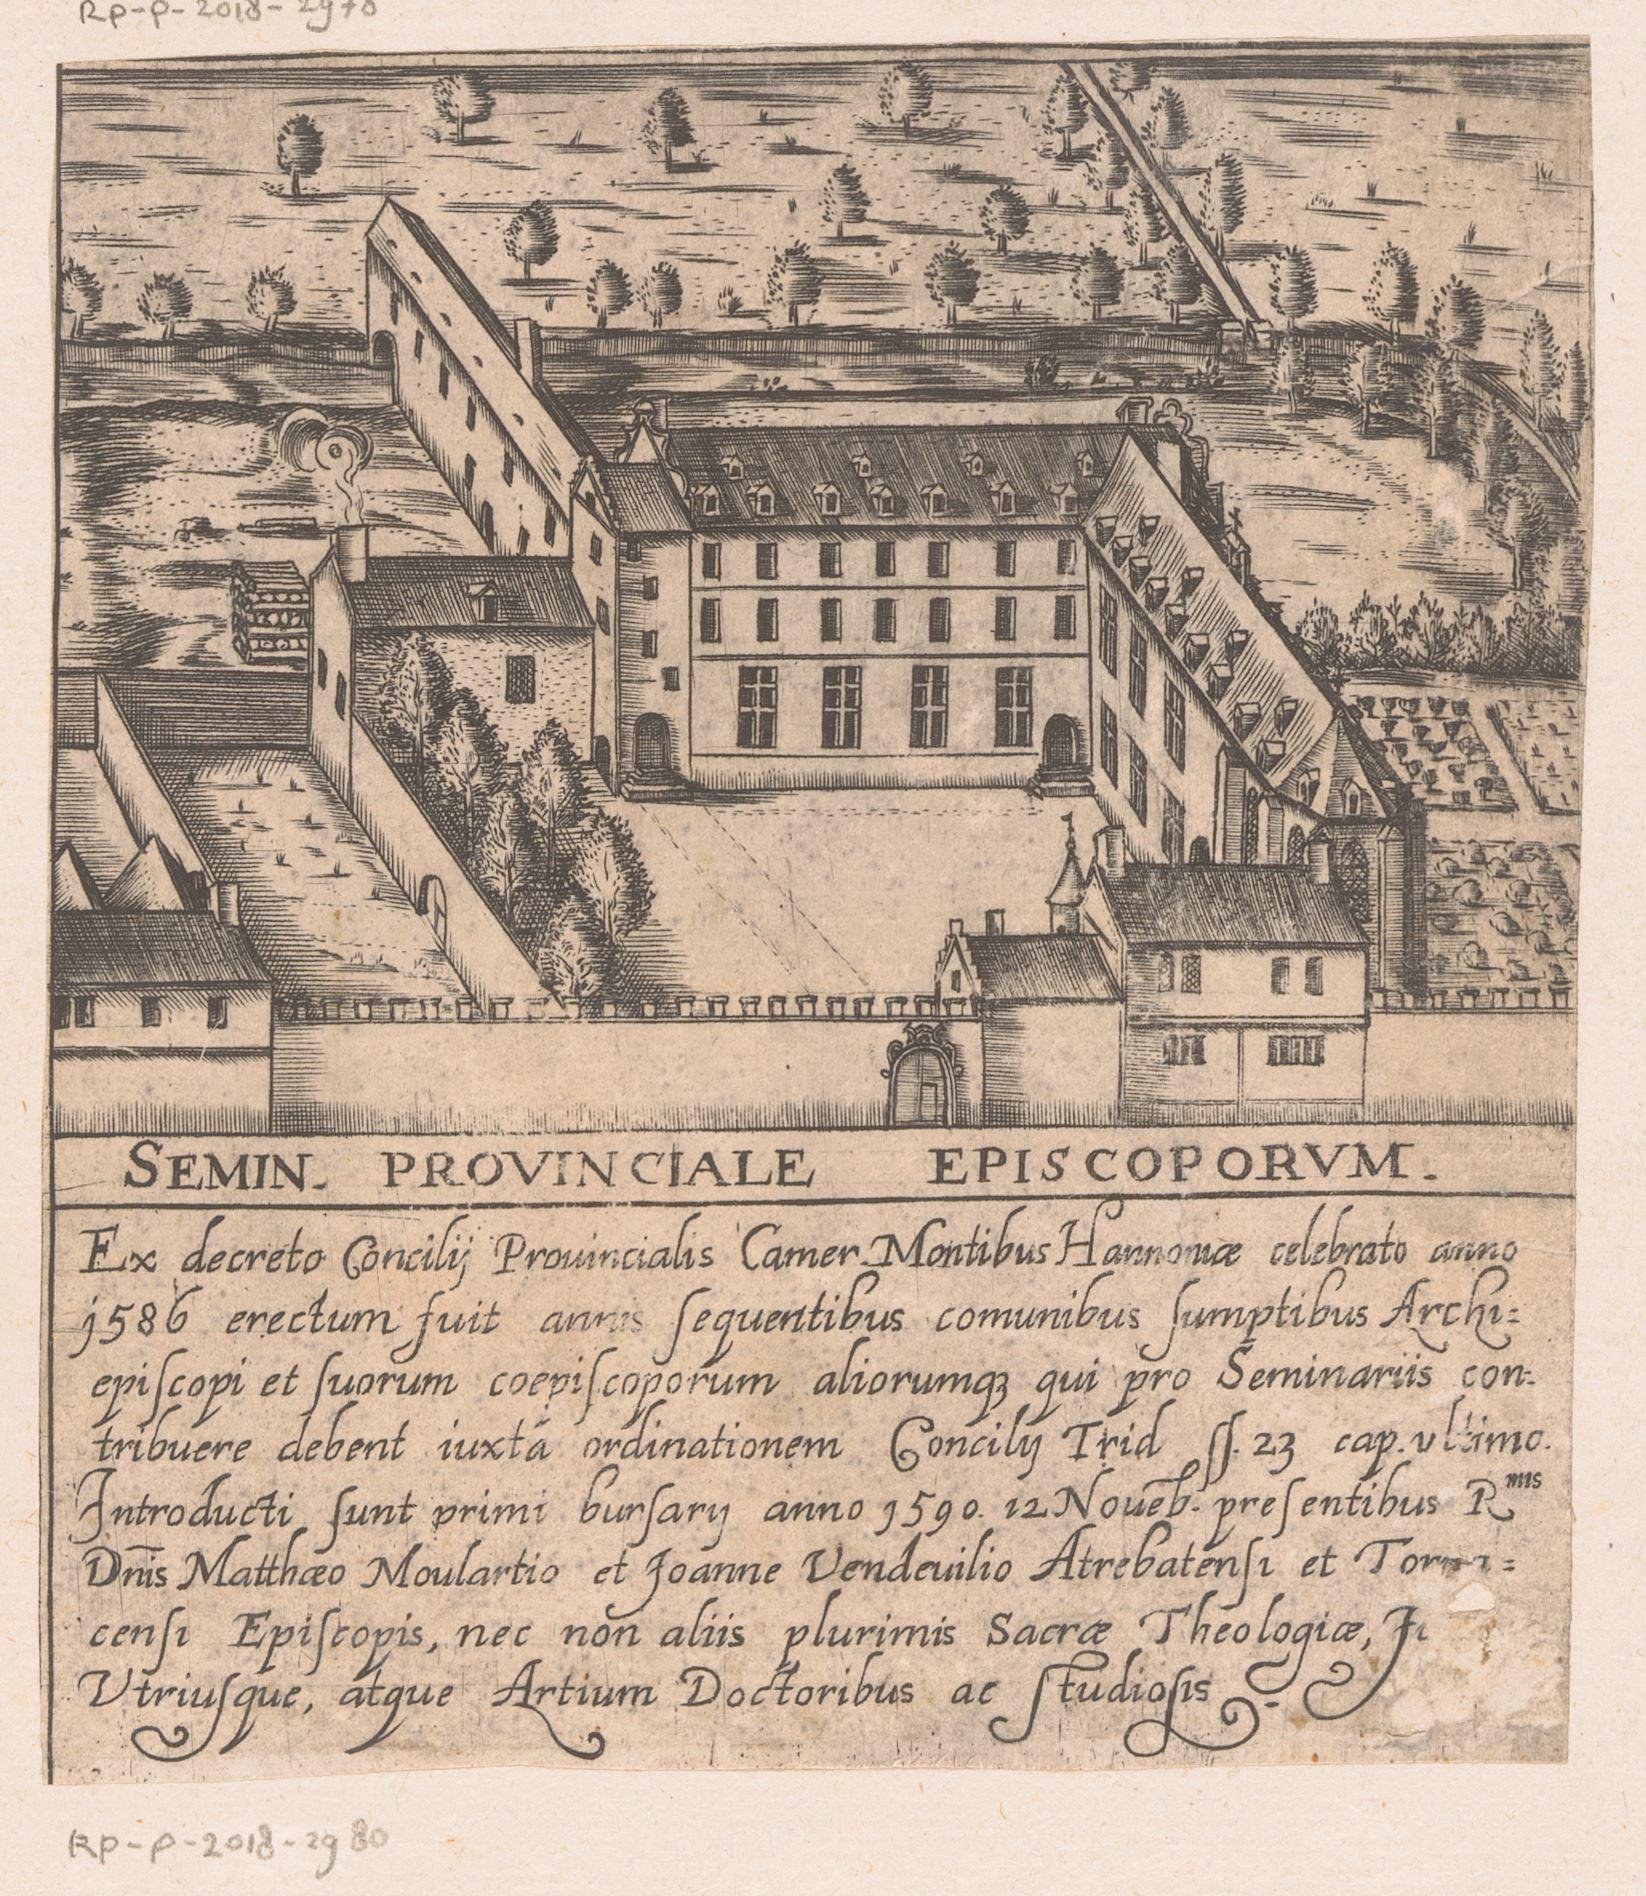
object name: book illustration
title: Semin. provinciale episcoporum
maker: filippo ferrari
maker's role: print maker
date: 1605-1680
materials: paper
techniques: etching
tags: prospect of city, town panorama, silhouette of city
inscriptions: collector's mark: Lugt 2228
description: Onderdeel van een reeks gezichten op steden/gebouwen met bijbehorend voorblad met tekst en legenda. De legendanummers zijn naast de afbeeldingen bijgeschreven. De afbeeldingen zijn per zes op één blad bevestigd.